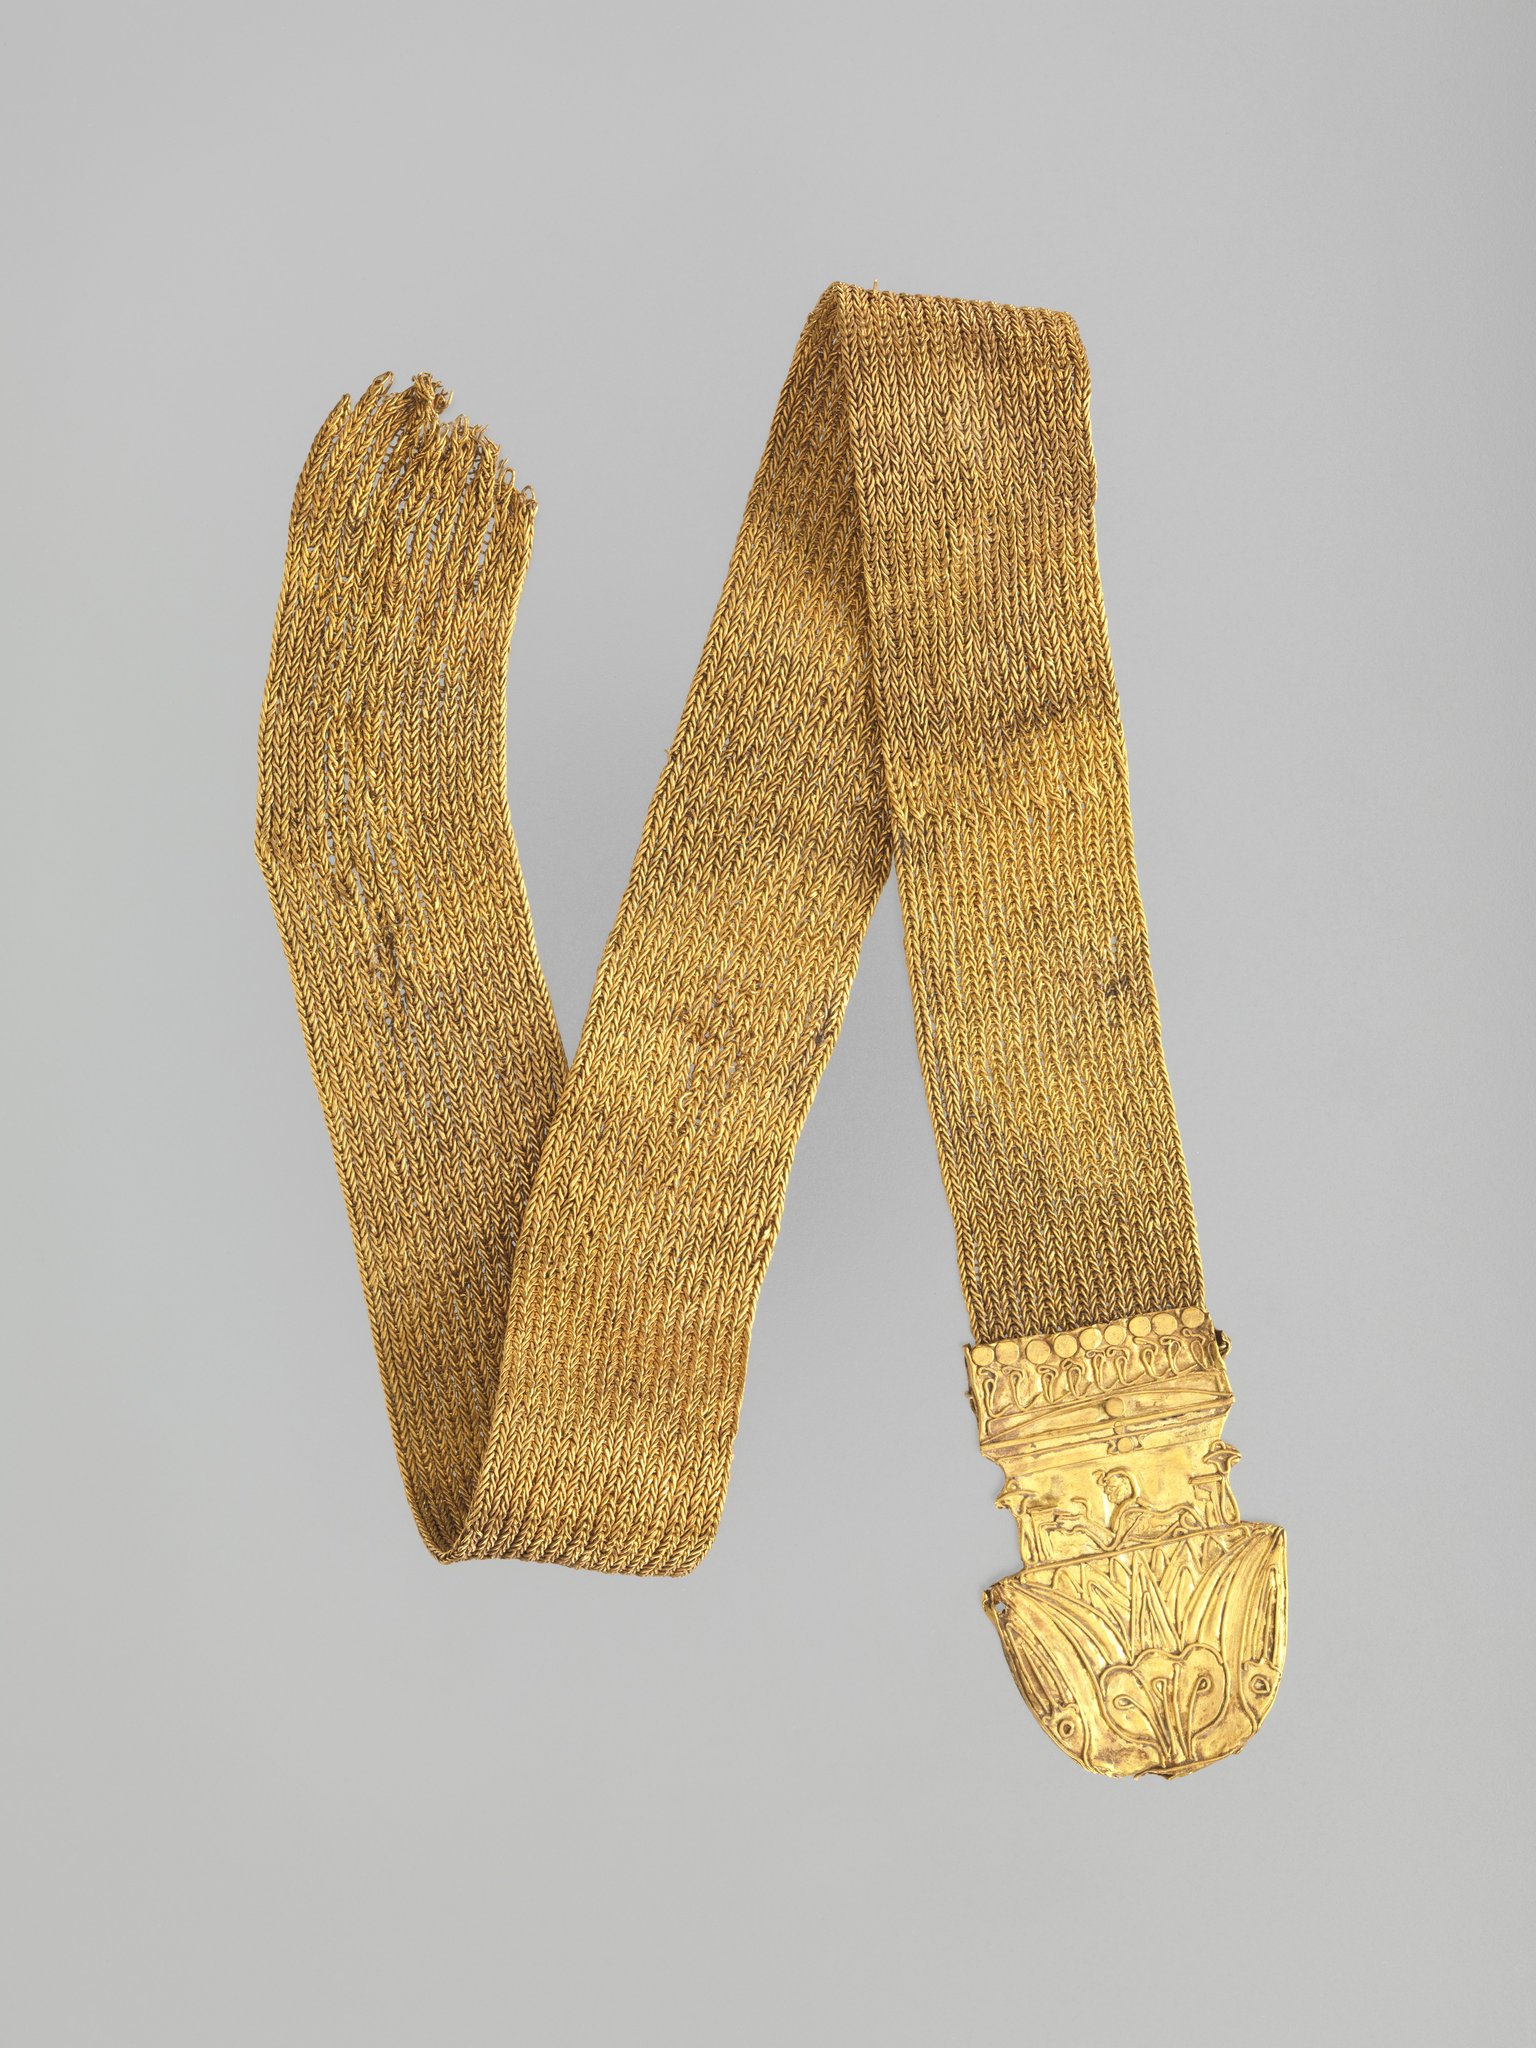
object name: strap chain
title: Strap chain with one decorated terminal preserved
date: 332-330 BCE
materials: gold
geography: egypt